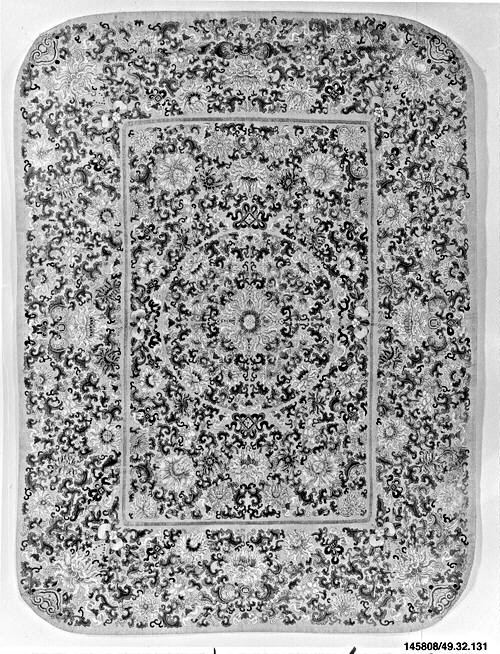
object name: furniture cover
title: Furniture Cover for Table (?)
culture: chinese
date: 1801-1833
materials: metal thread, paint, silk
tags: flowers